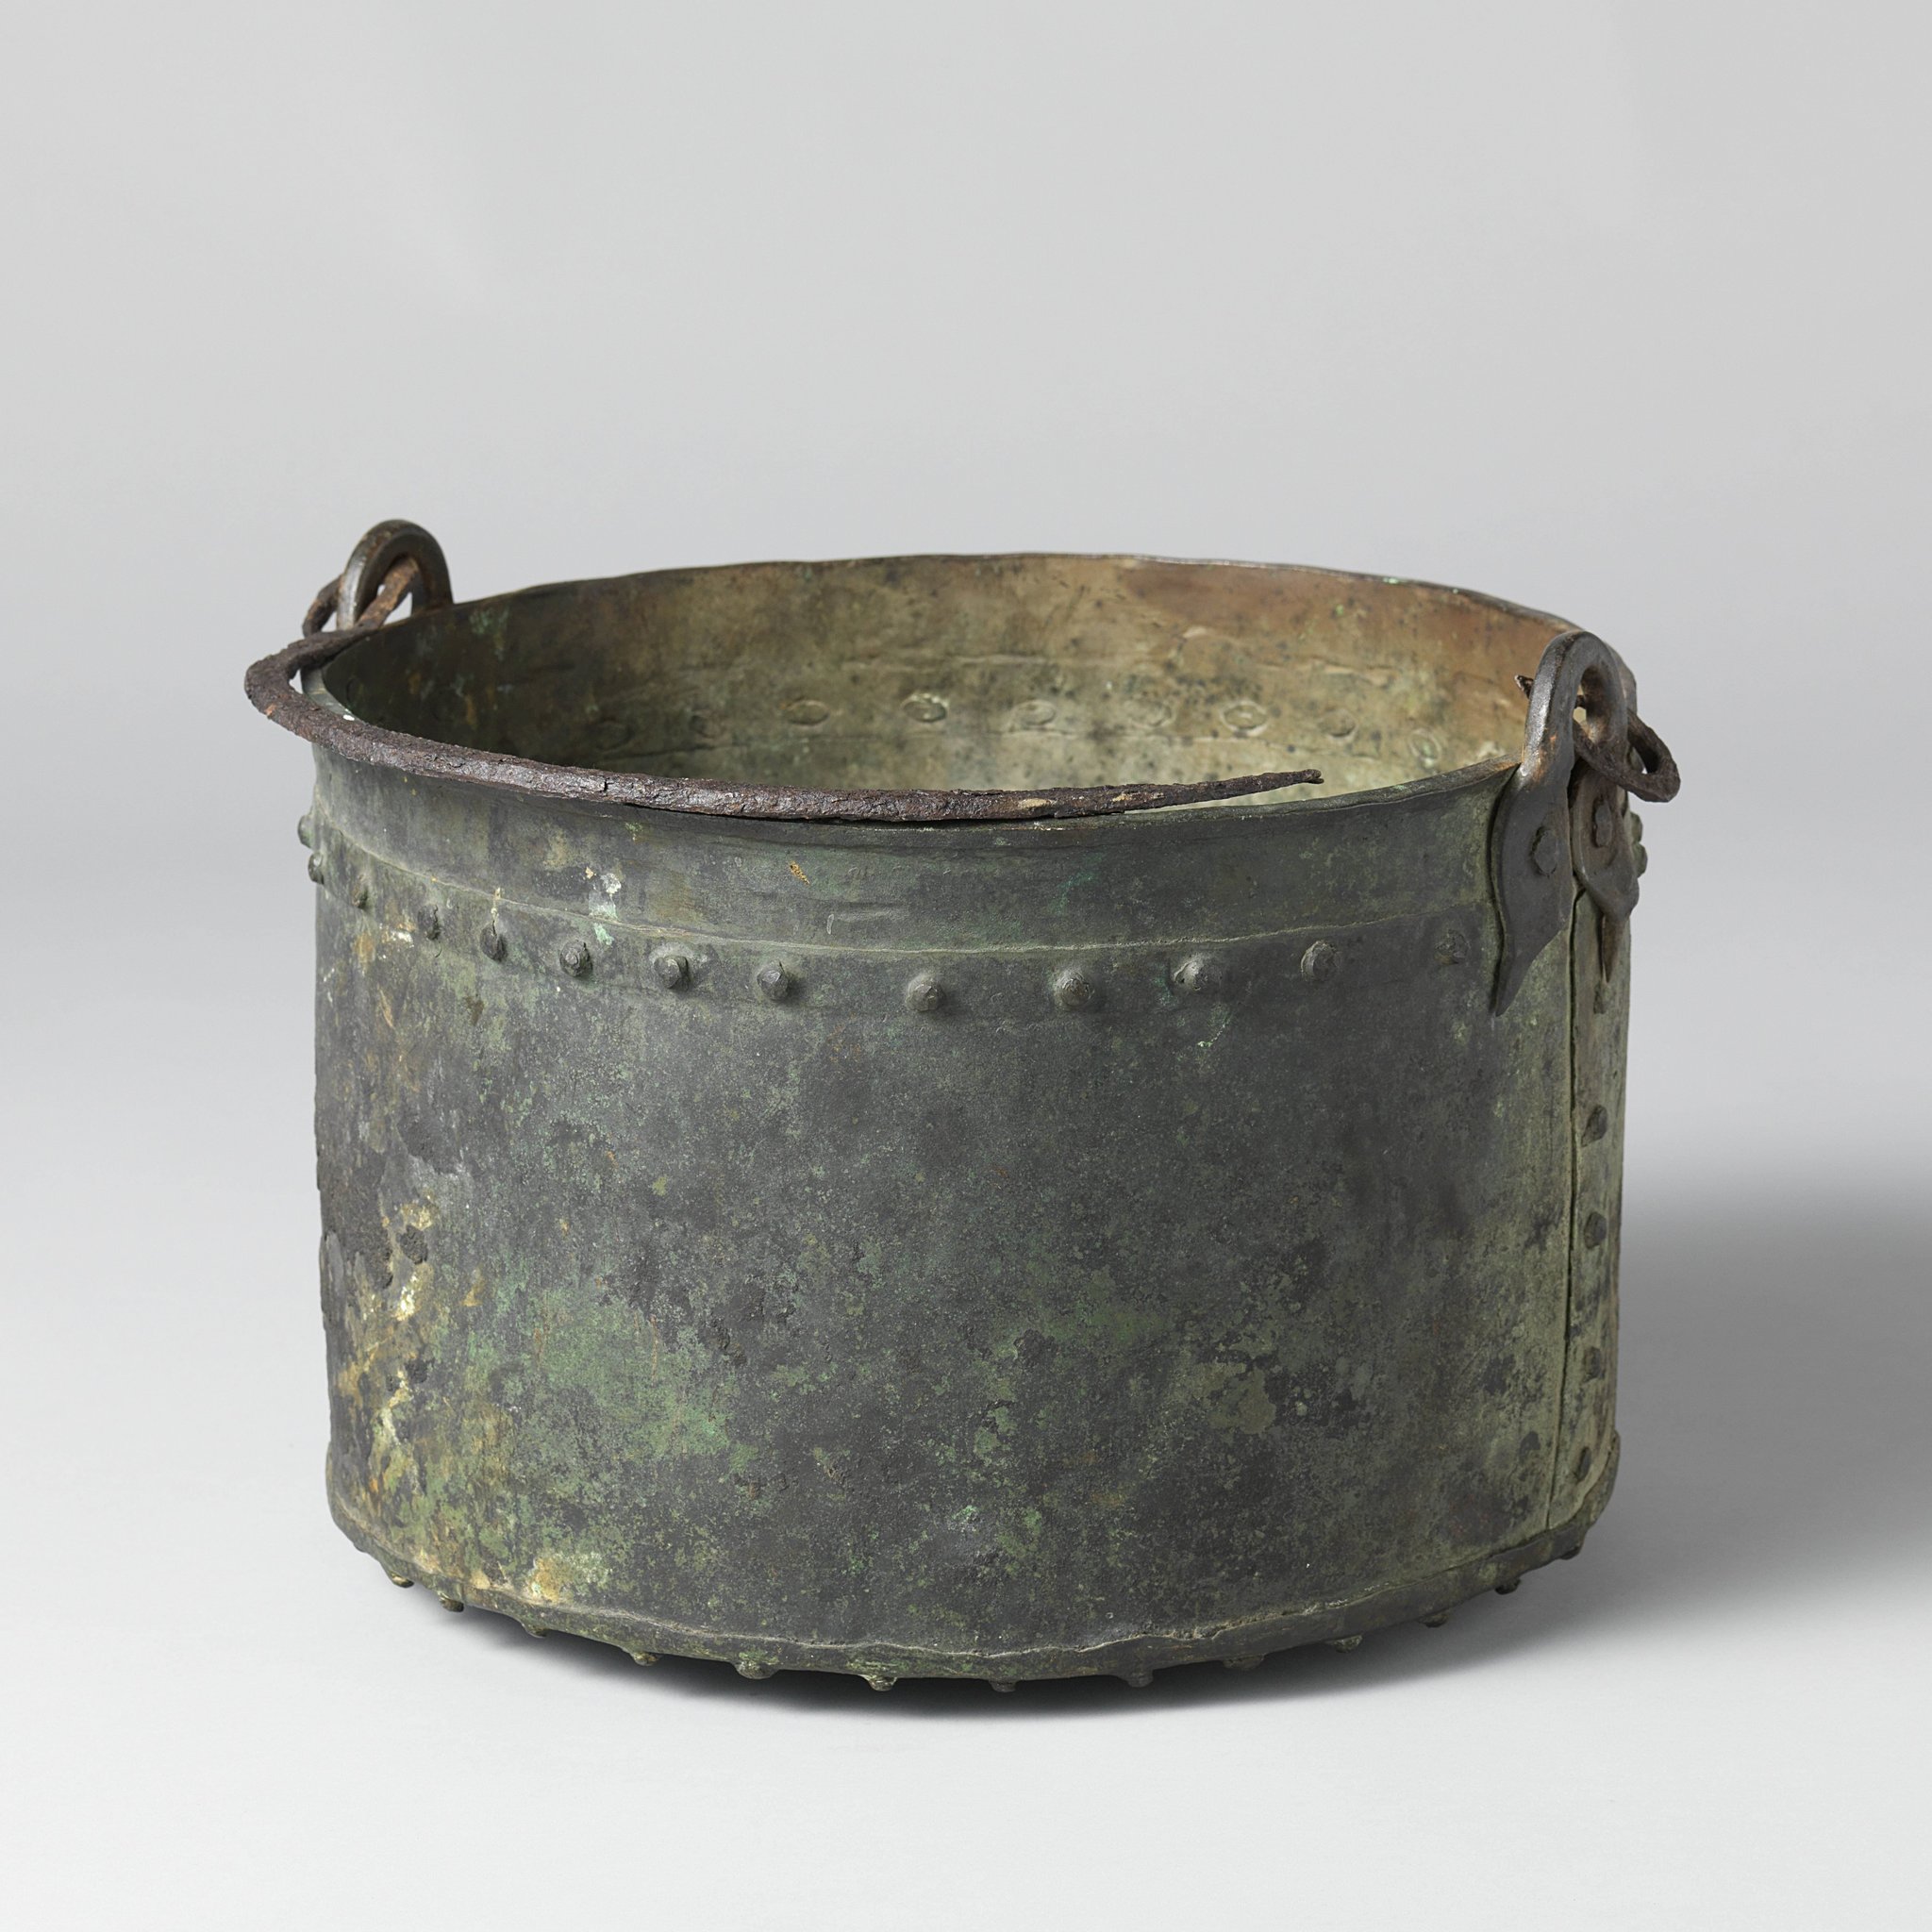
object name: kettle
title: Andiron with cooking pots and a pair of fire tongs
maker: Anonymous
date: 1590-1596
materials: copper, iron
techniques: striking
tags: willem barendsz., amsterdam, jacob van heemskerck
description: Centrally located in the ‘Safe House’ was a fireplace with a chimney above it. The food was cooked there and the men could warm themselves by the open hearth. When the ‘Safe House’ was rediscovered at the end of the 19th century, the andiron and the cooking pots were still in place.